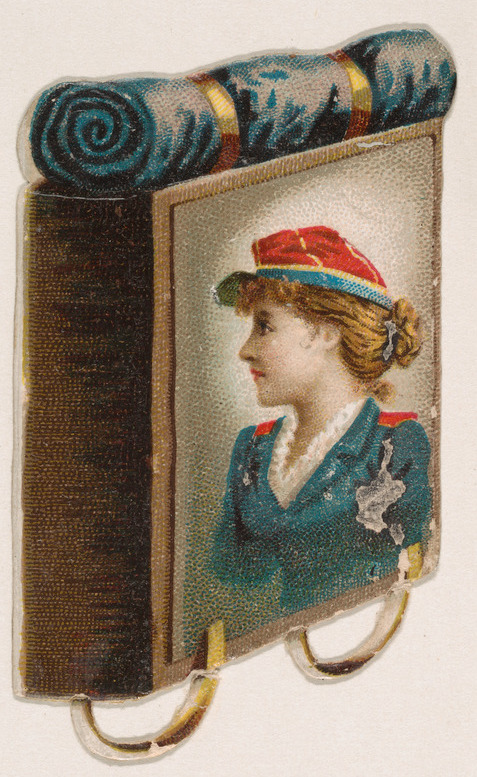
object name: print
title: Backpack, from the Novelties series (N228, Type 4) issued by Kinney Bros.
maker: kinney brothers tobacco company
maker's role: publisher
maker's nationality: american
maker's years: 1869-2011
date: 1889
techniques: color lithograph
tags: women